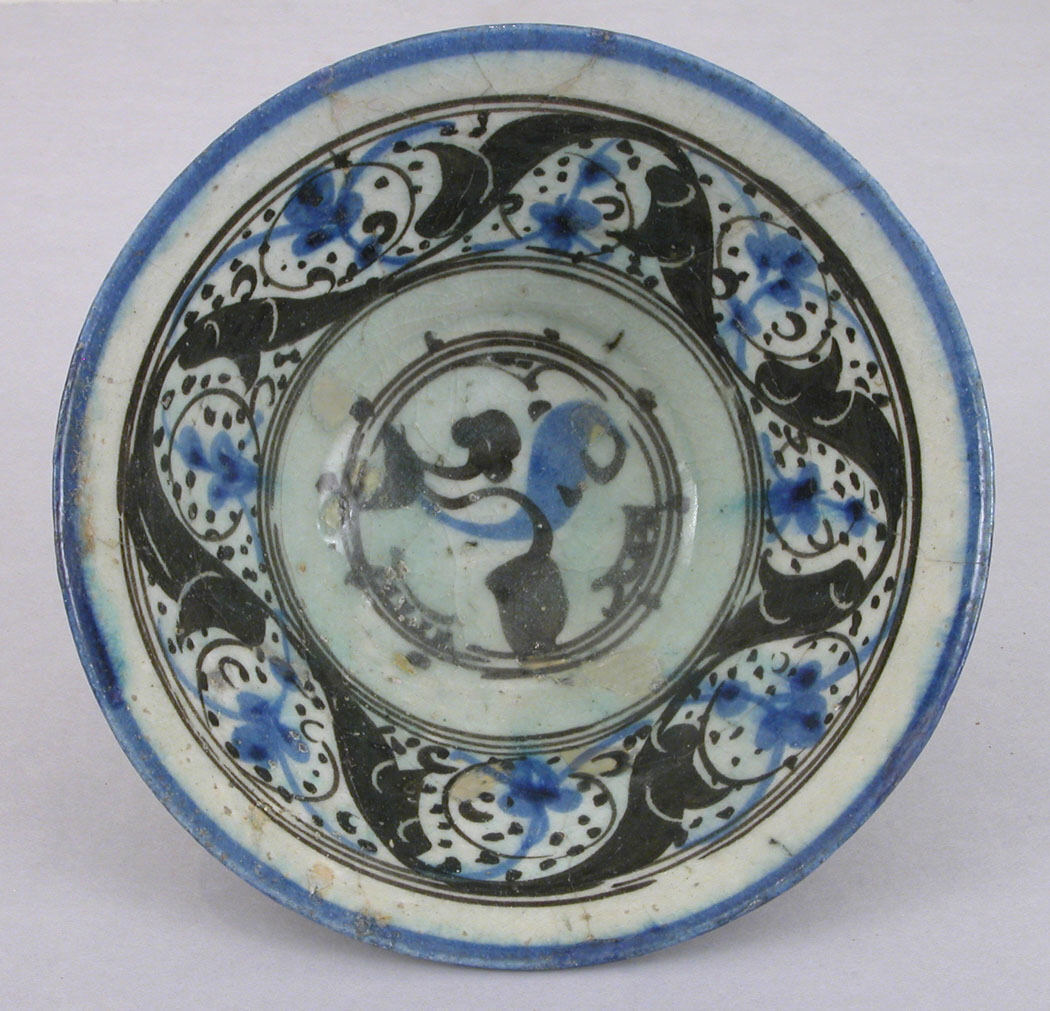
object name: bowl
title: Bowl with Vegetal Motifs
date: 1101-1200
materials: glaze, stonepaste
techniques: incising, painting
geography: syria